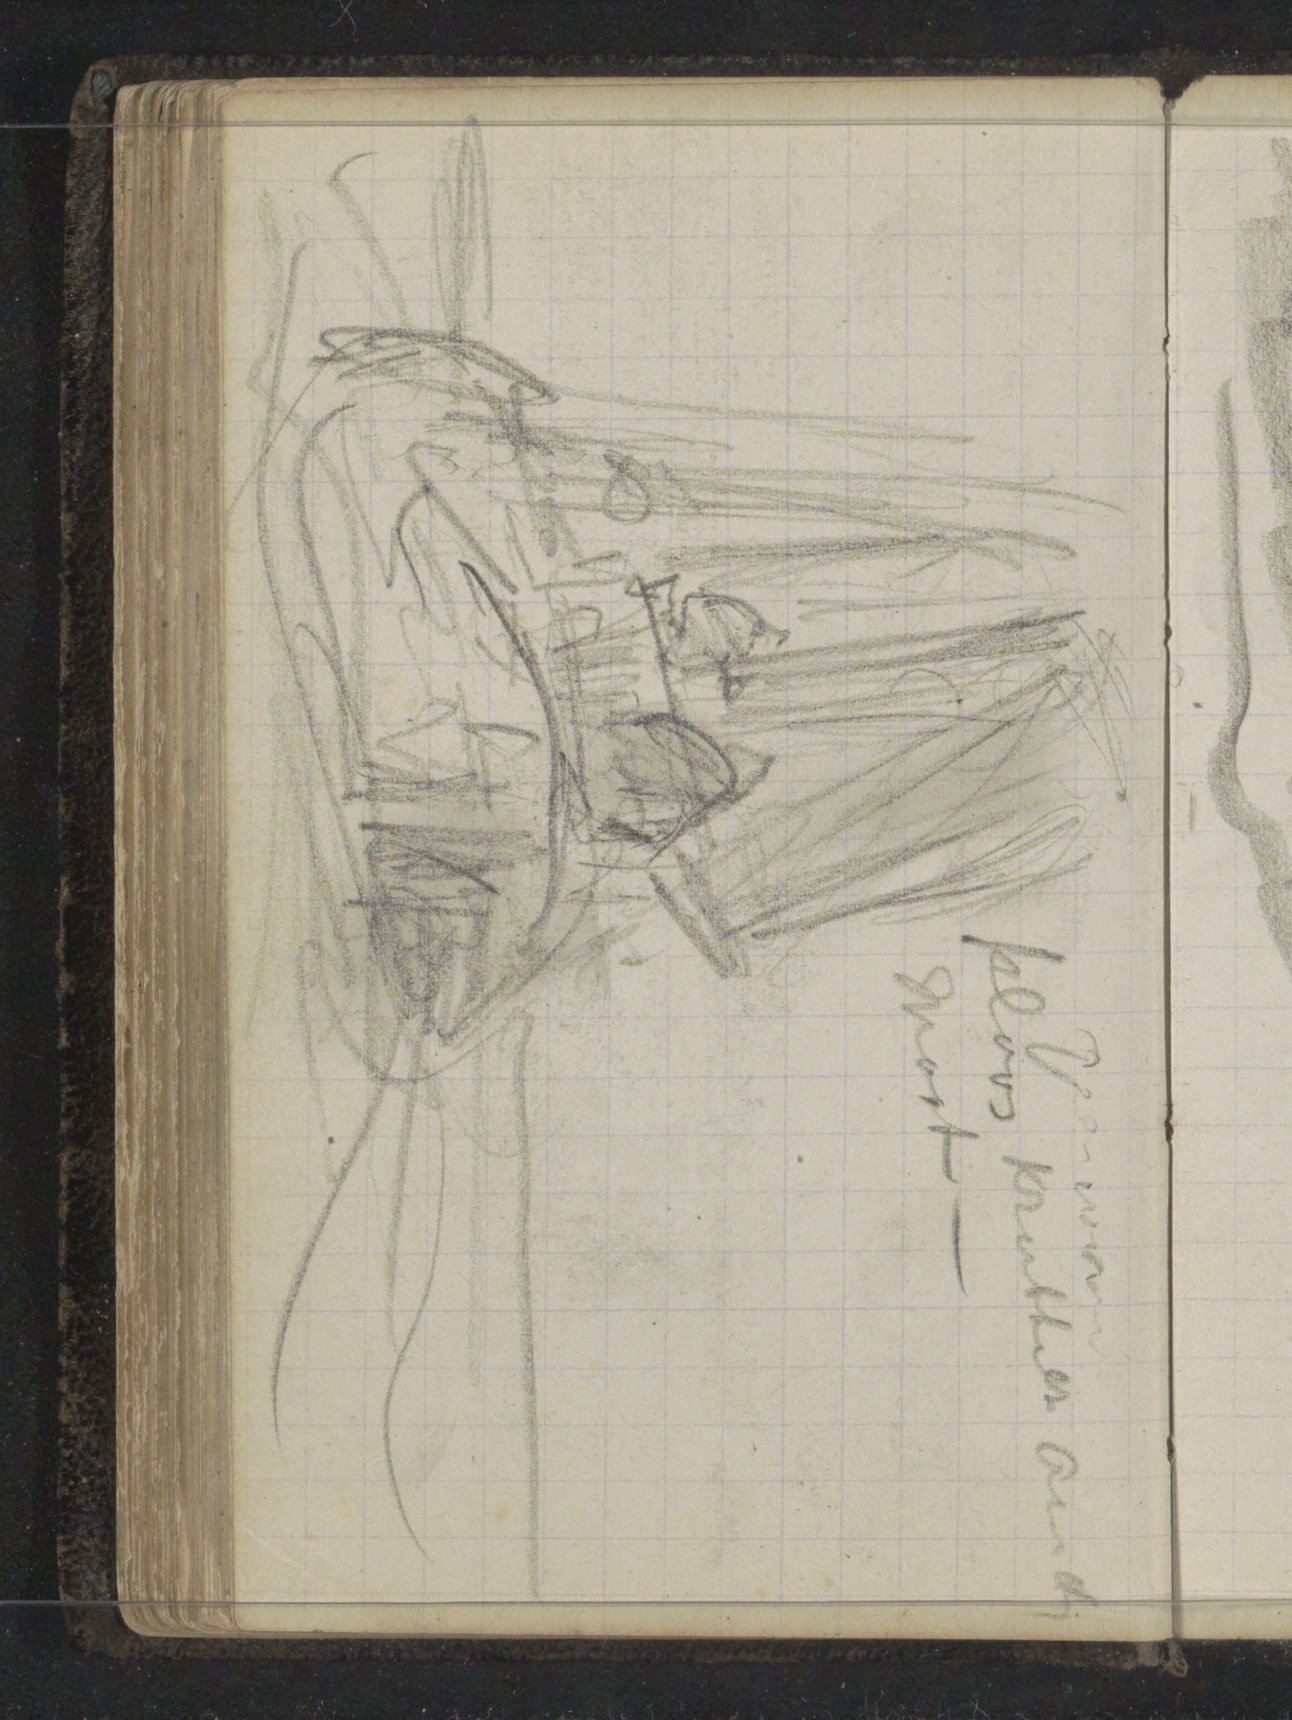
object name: sketchbook leaf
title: Zeilschip met twee bemanningsleden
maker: louis apol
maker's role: draughtsman, painter, print maker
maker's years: 1850-1936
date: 1809-1880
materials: pencil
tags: sailing-ship, sailing-boat, sea (seascape)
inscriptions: annotation: ‘Klaas Krubbier[?] aan de / mast’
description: Blad 50 verso uit een schetsboek met 110 bladen betekend tijdens de expeditie naar Nova Zembla in 1880.